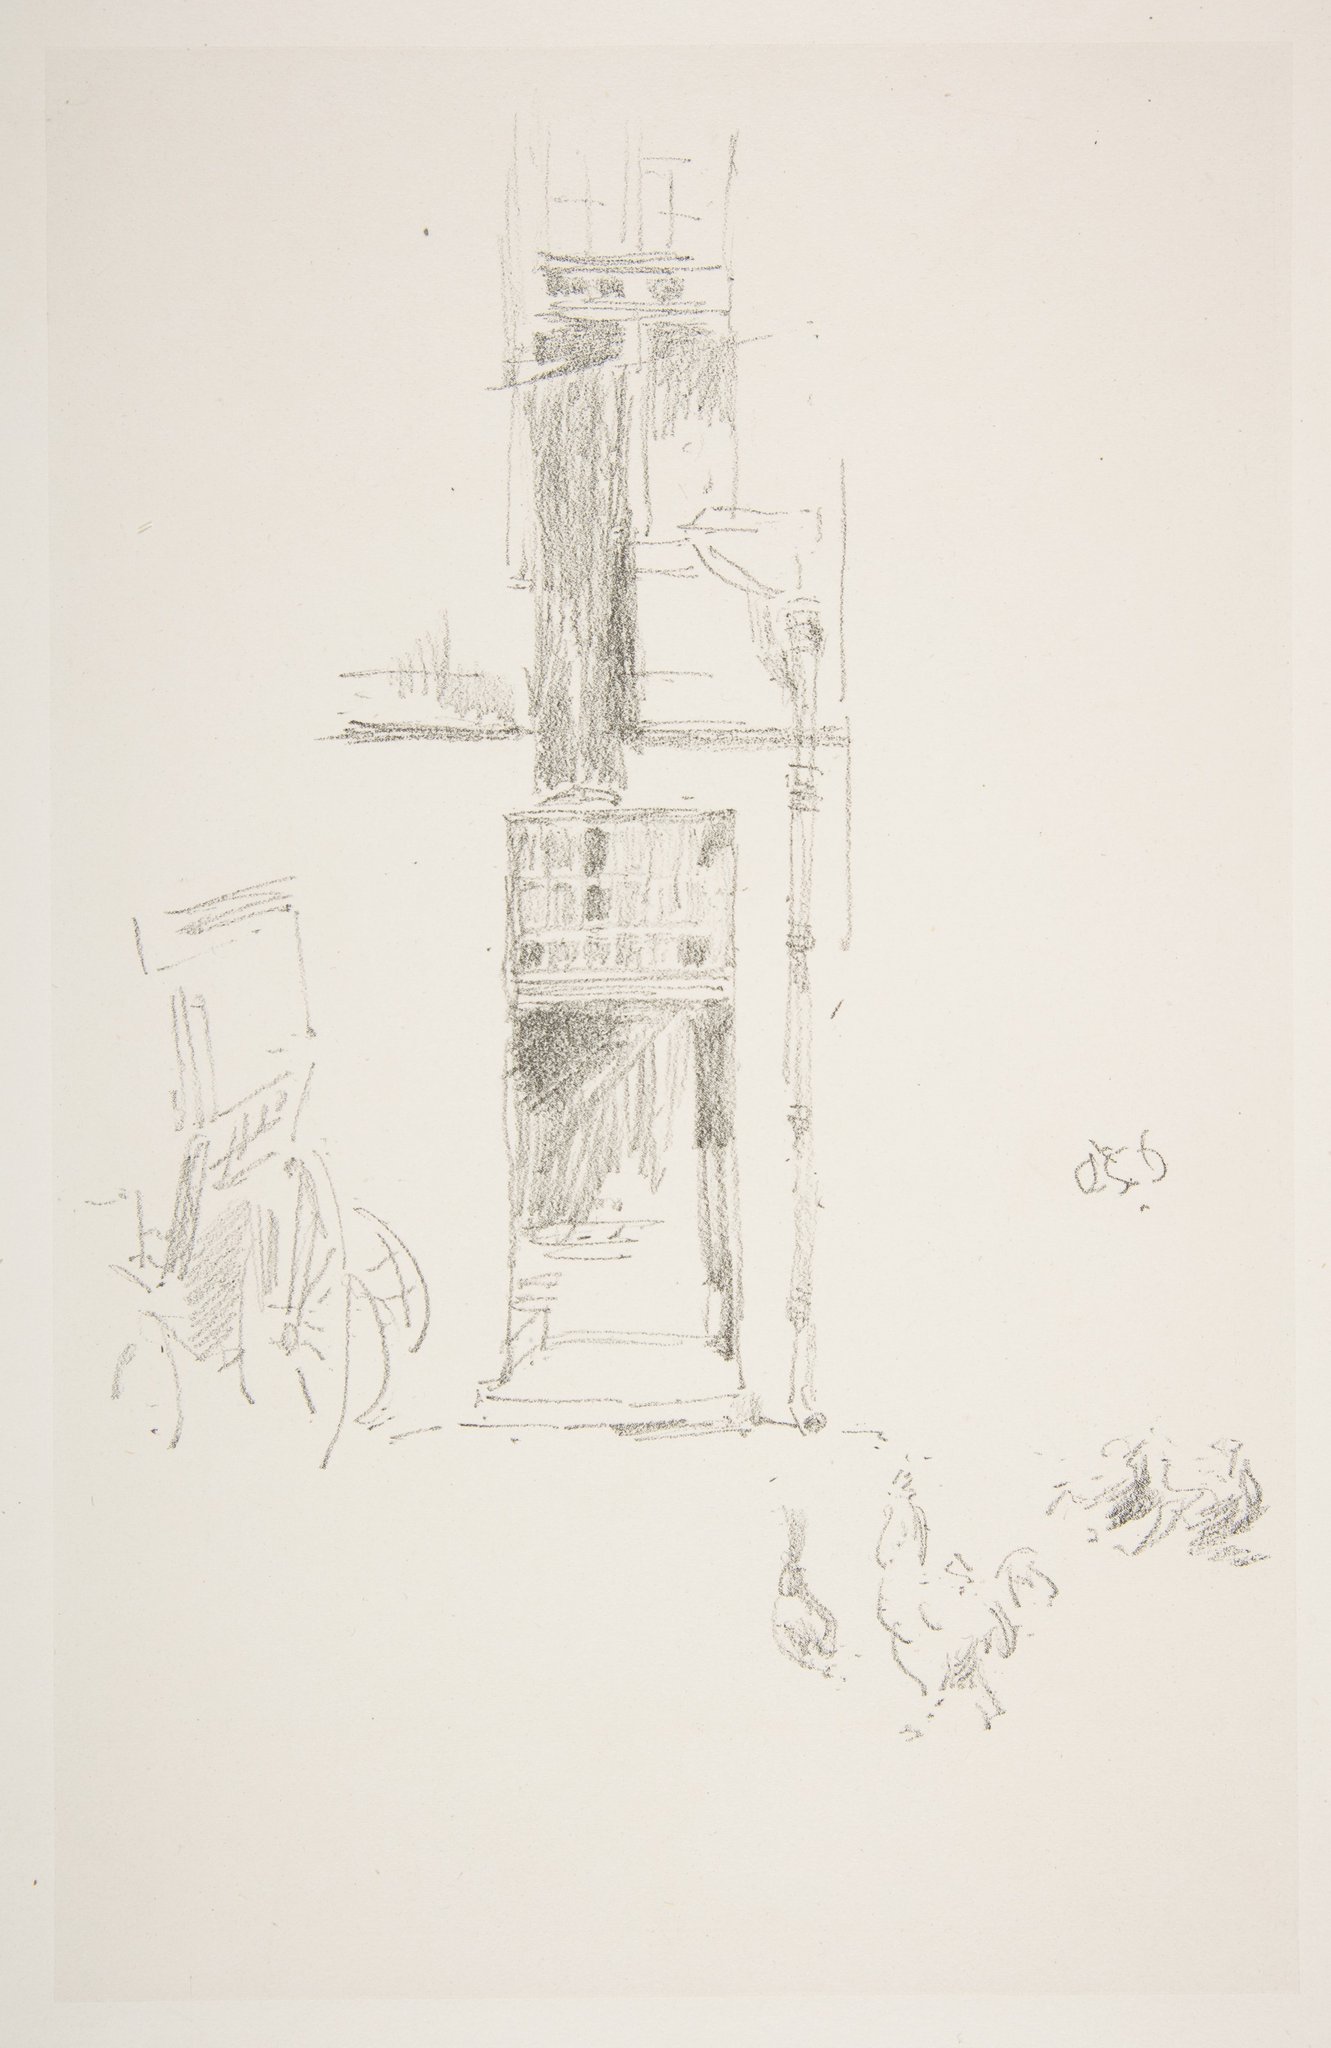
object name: print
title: Cocks and Hens, Hôtel Colbert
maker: james mcneill whistler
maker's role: artist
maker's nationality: american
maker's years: 1834-1903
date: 1891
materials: chine, ivory, paper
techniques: printing, lithography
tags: chickens,buildings,roosters